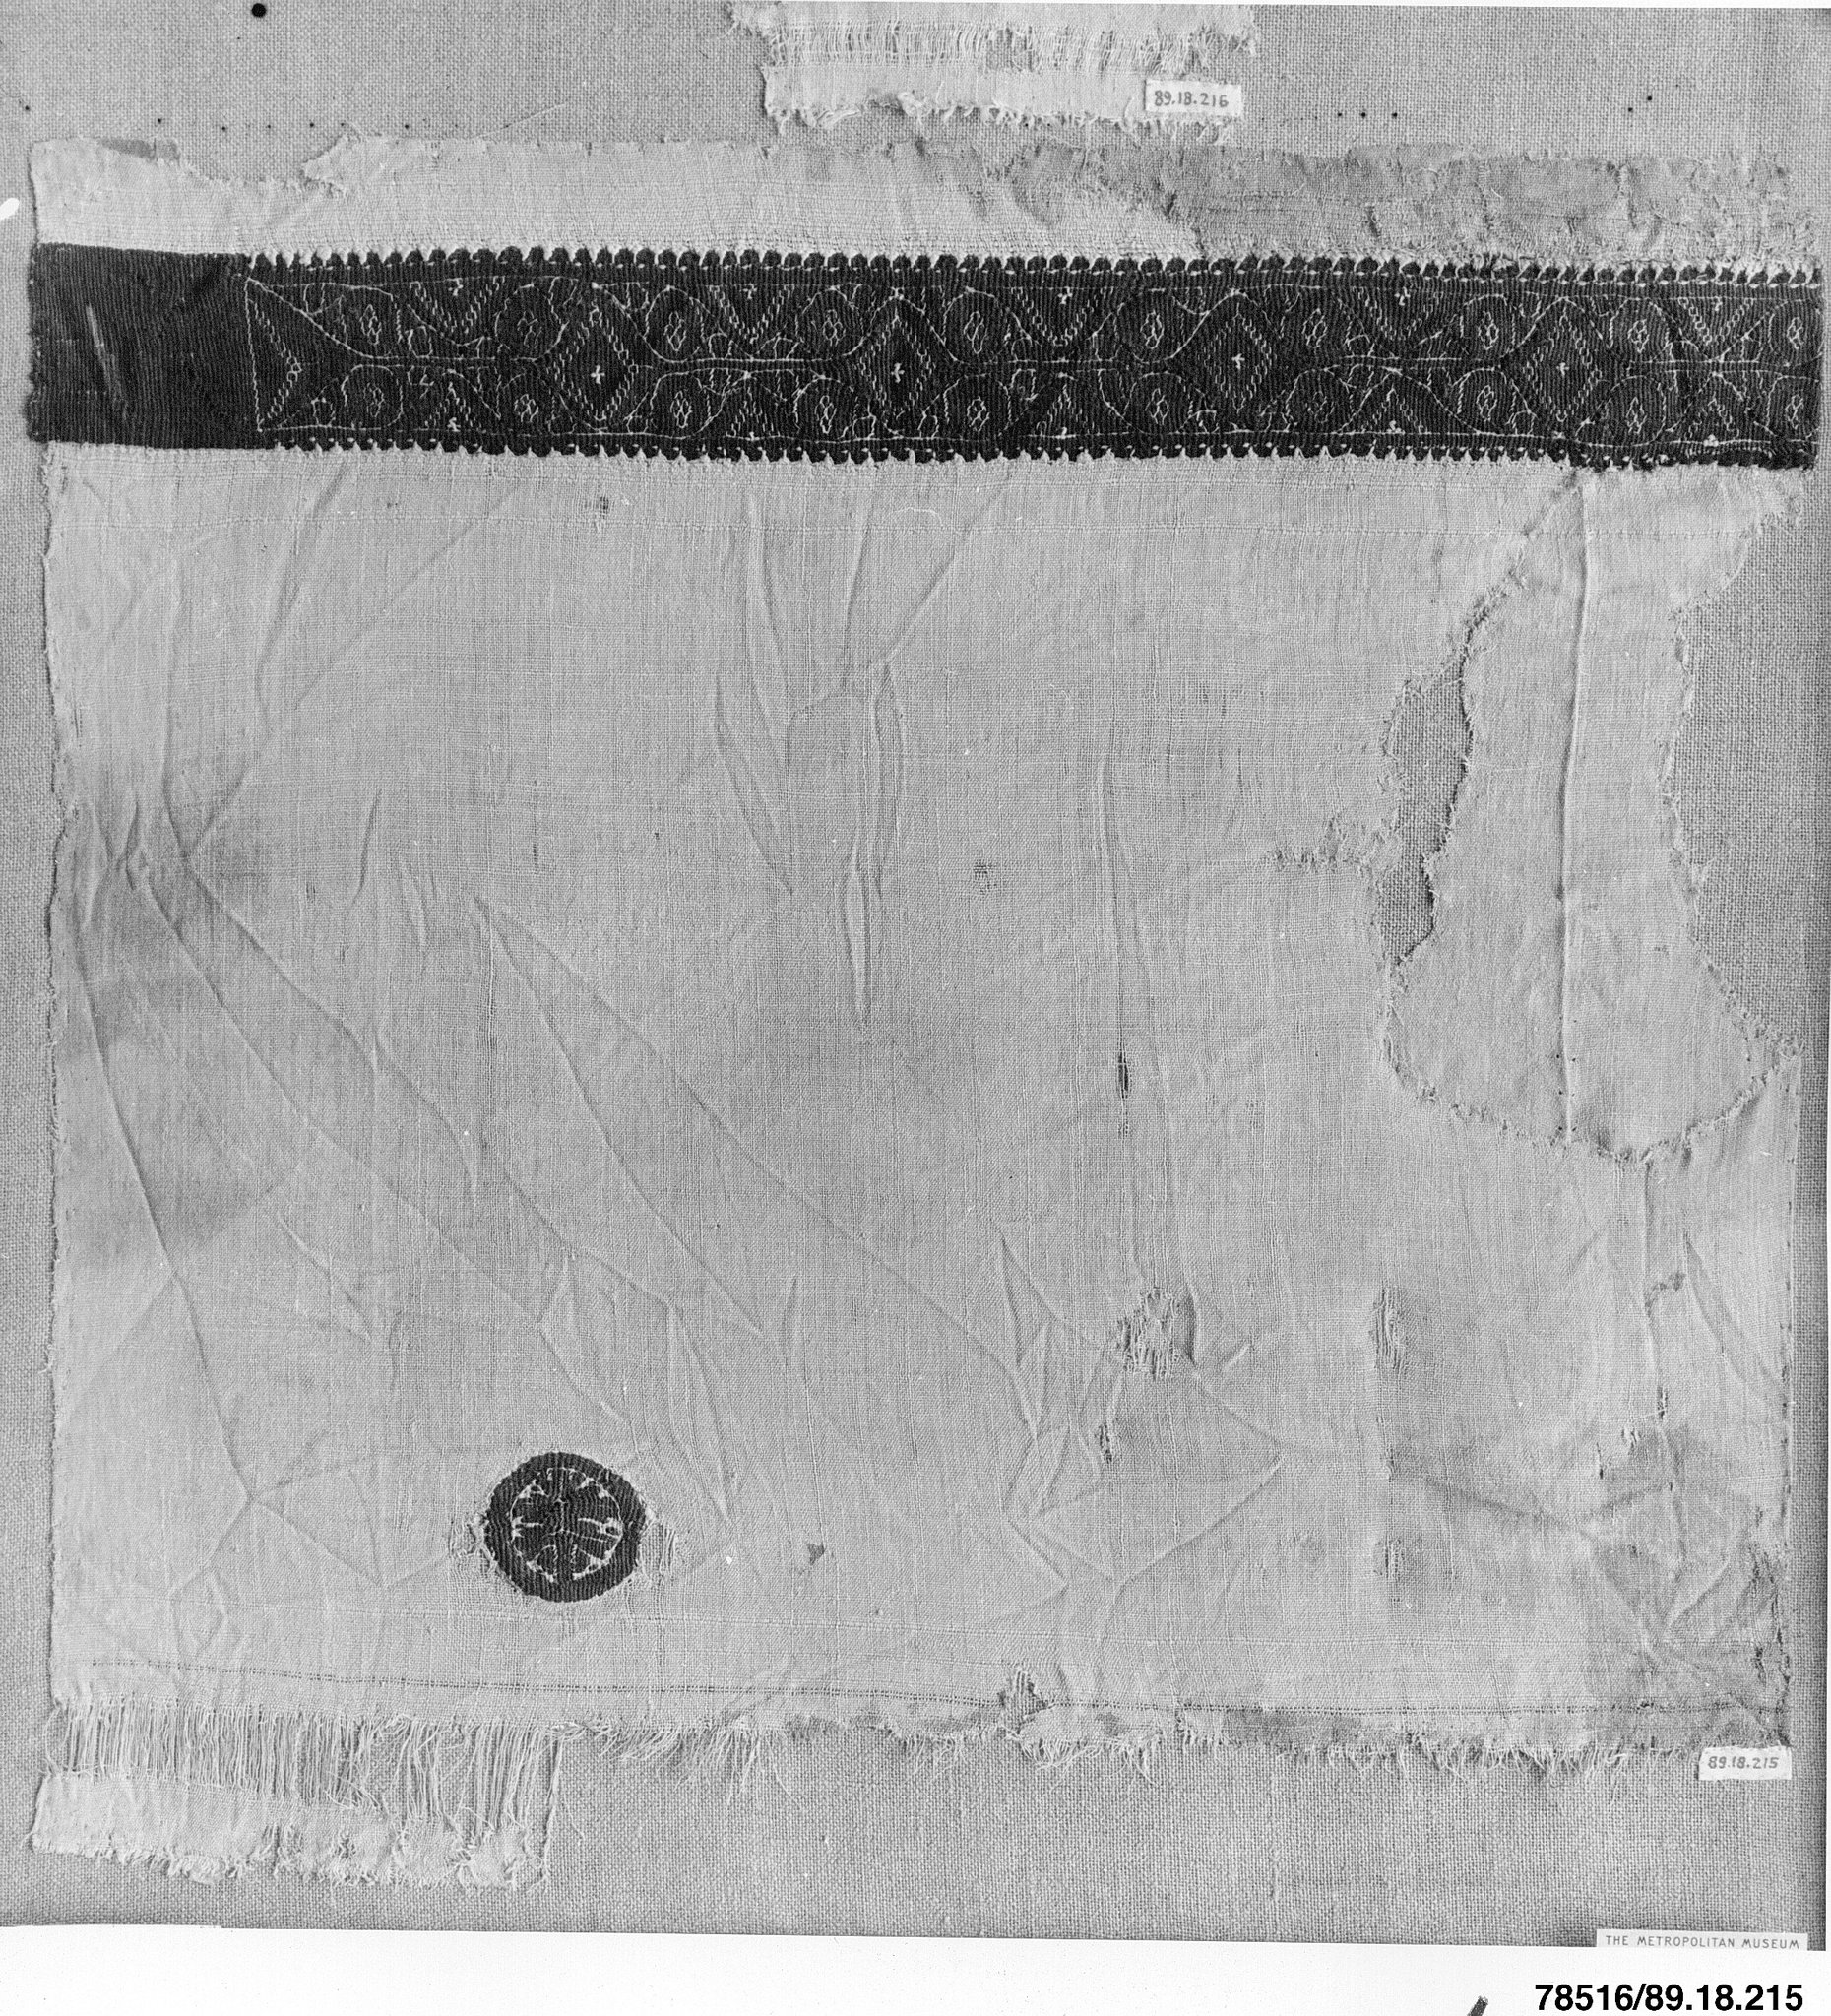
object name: textile fragment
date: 201-400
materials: linen, wool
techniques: weave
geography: egypt